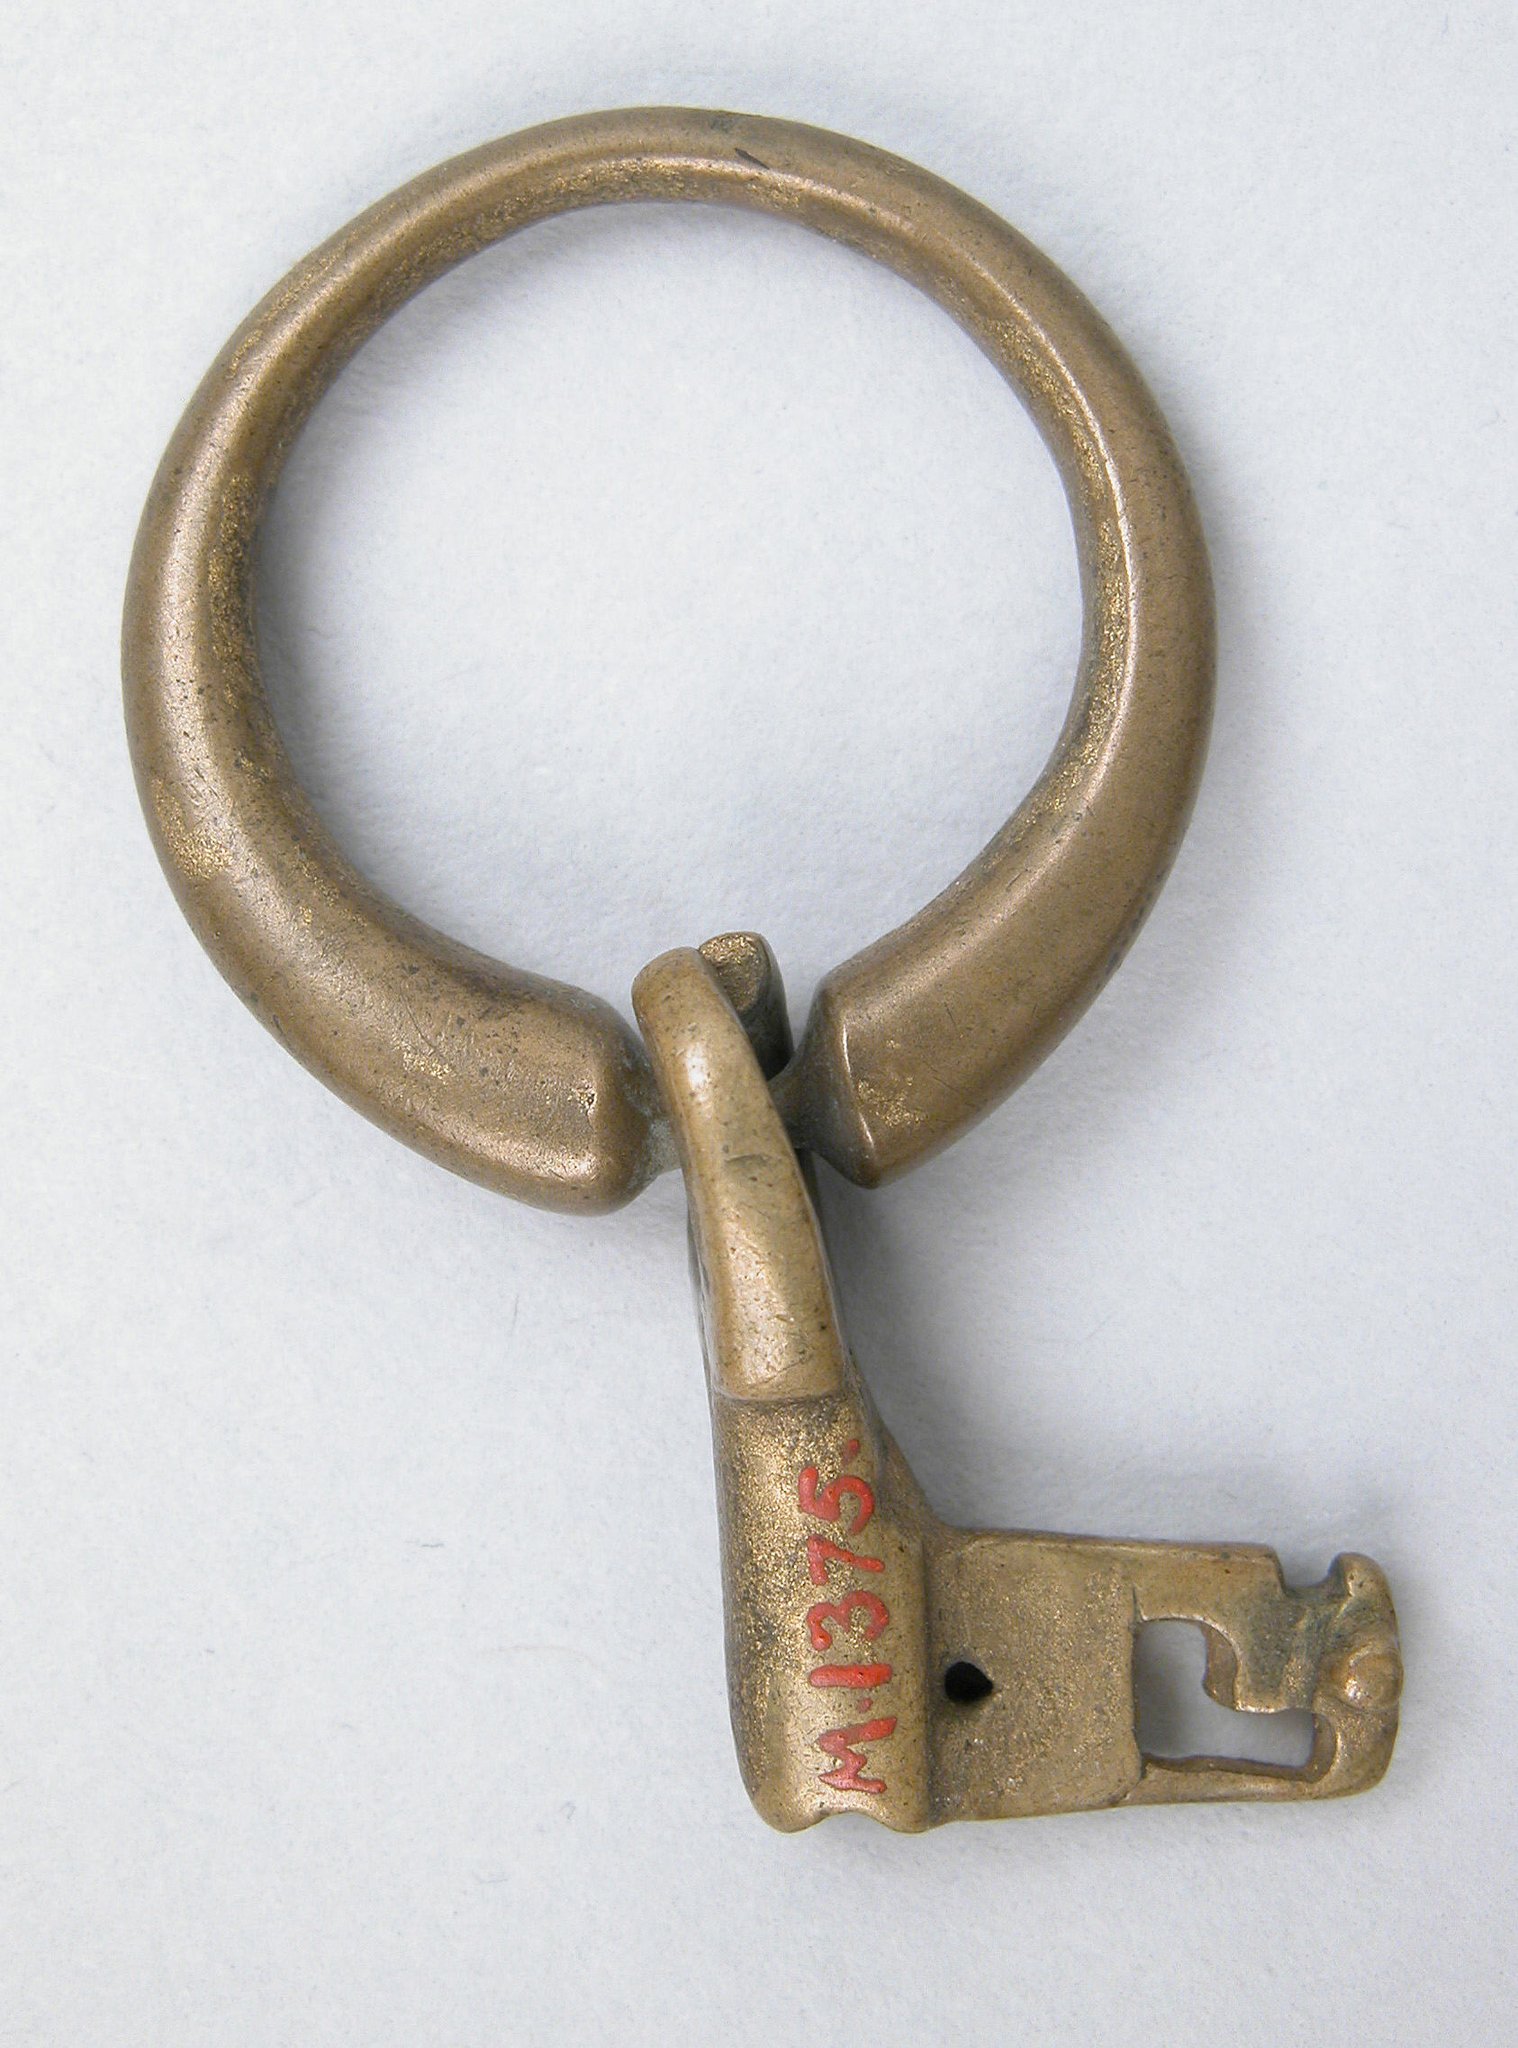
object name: key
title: Key on Ring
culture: byzantine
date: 395-640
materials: copper alloy